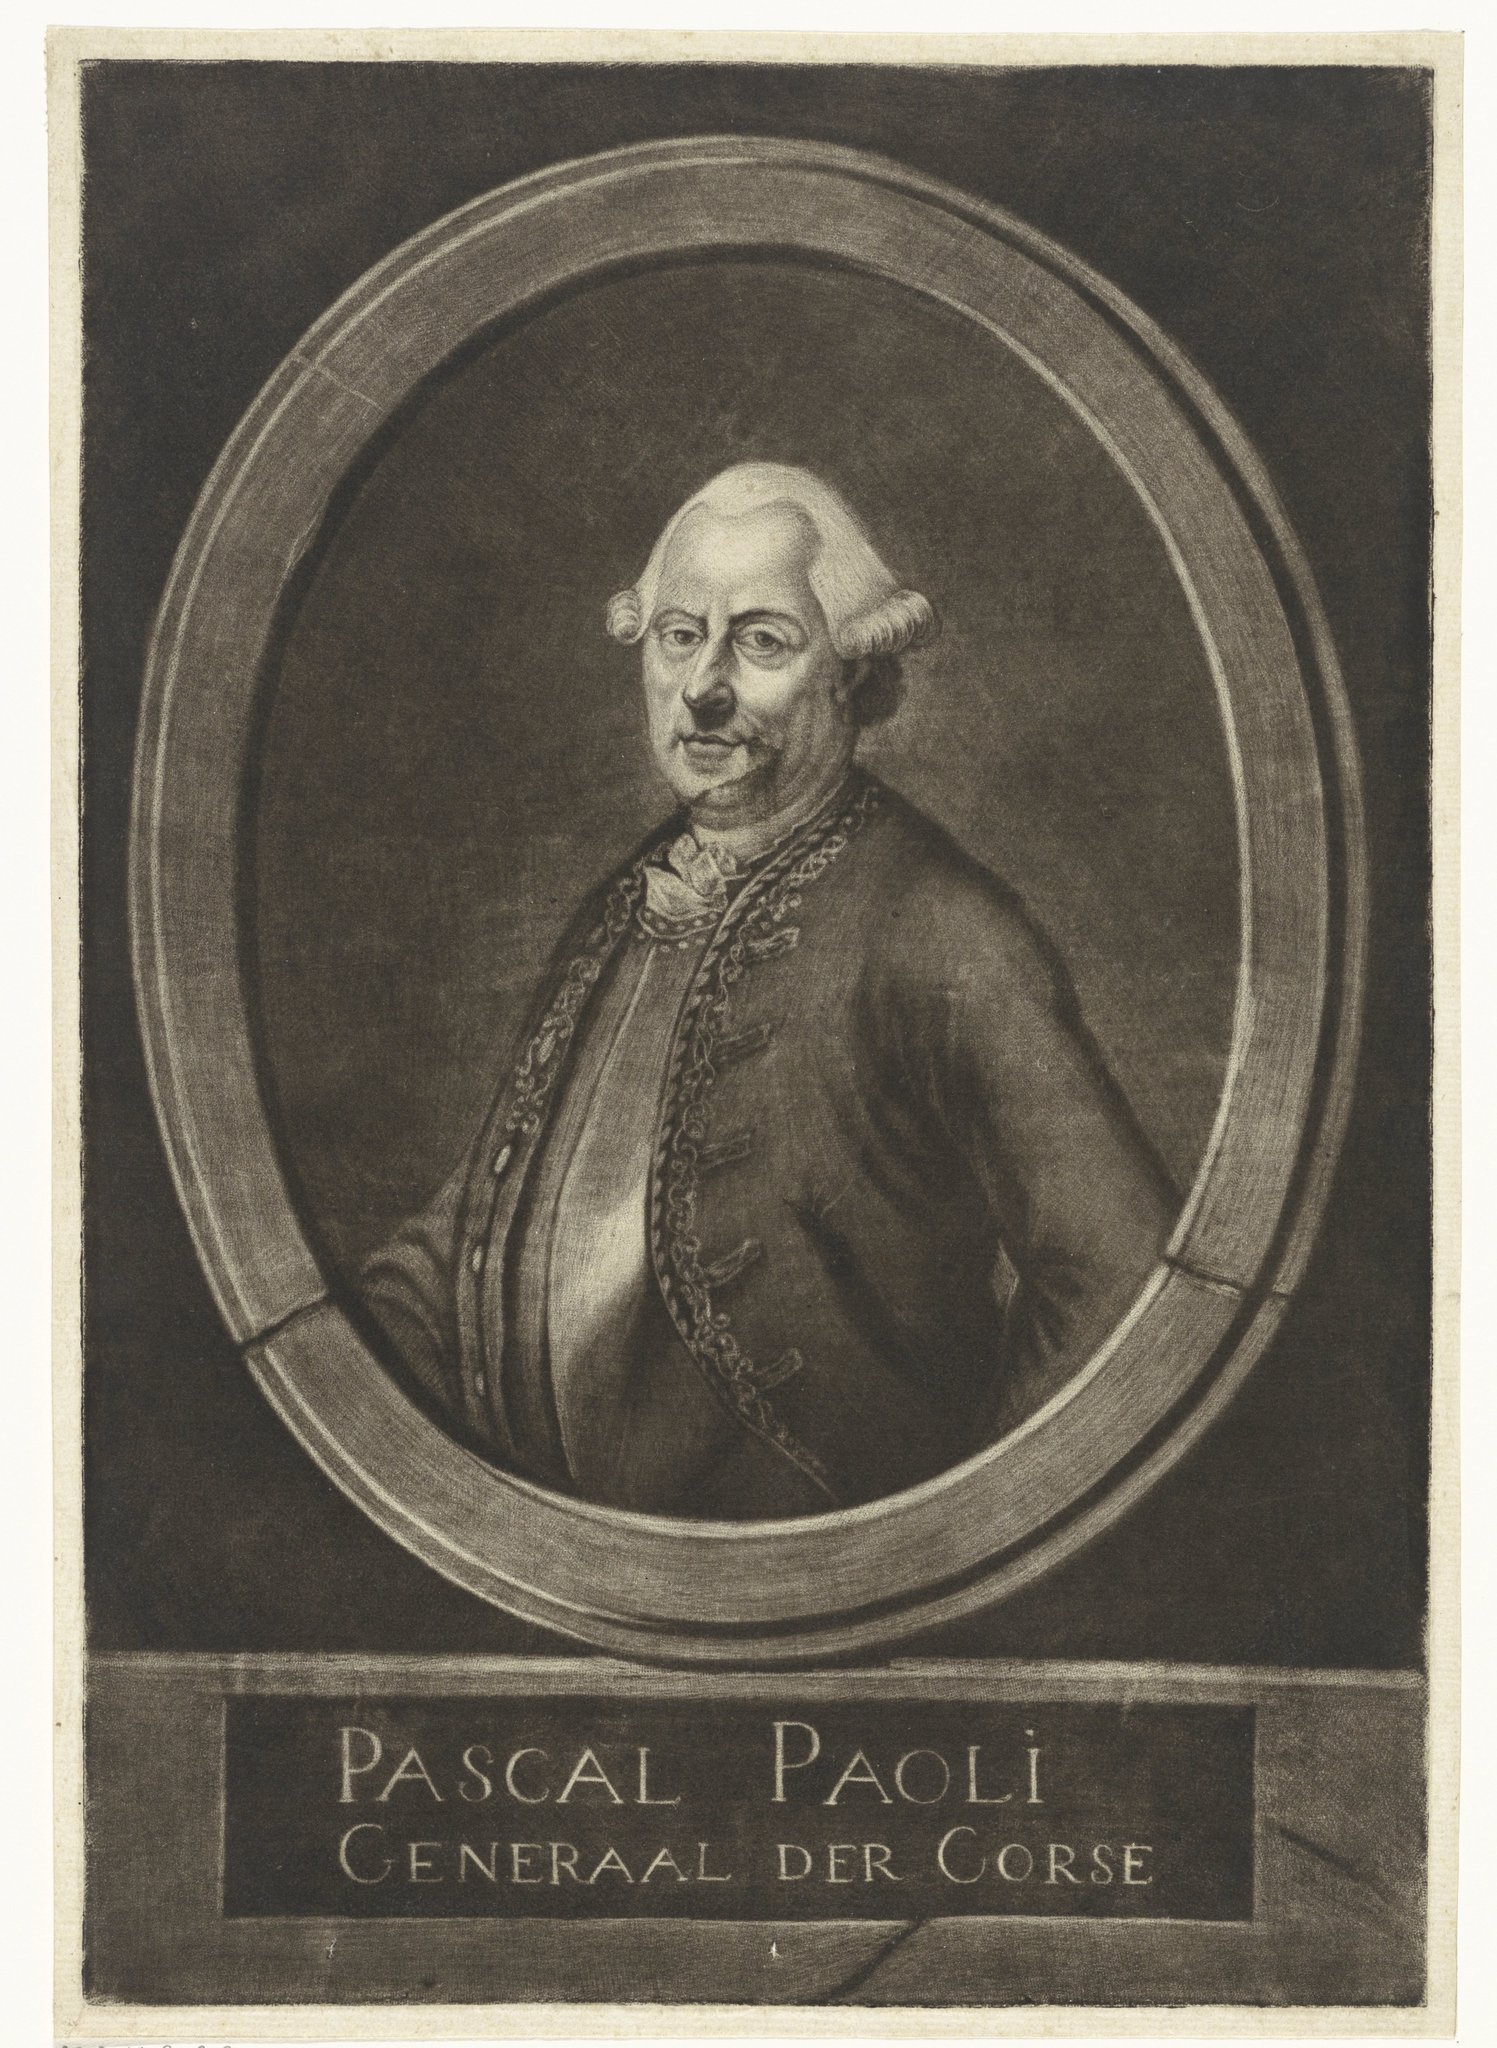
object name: print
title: Portret van Pascal Paoli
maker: rienk jelgerhuis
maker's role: draughtsman, print maker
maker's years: 1729-1806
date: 1755-1806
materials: paper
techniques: mezzotint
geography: northern netherlands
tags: morosaglia, militair, pasquale paoli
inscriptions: collector's mark: Lugt 2228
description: Pascal Paoli, generaal en leider van de Corsicanen.